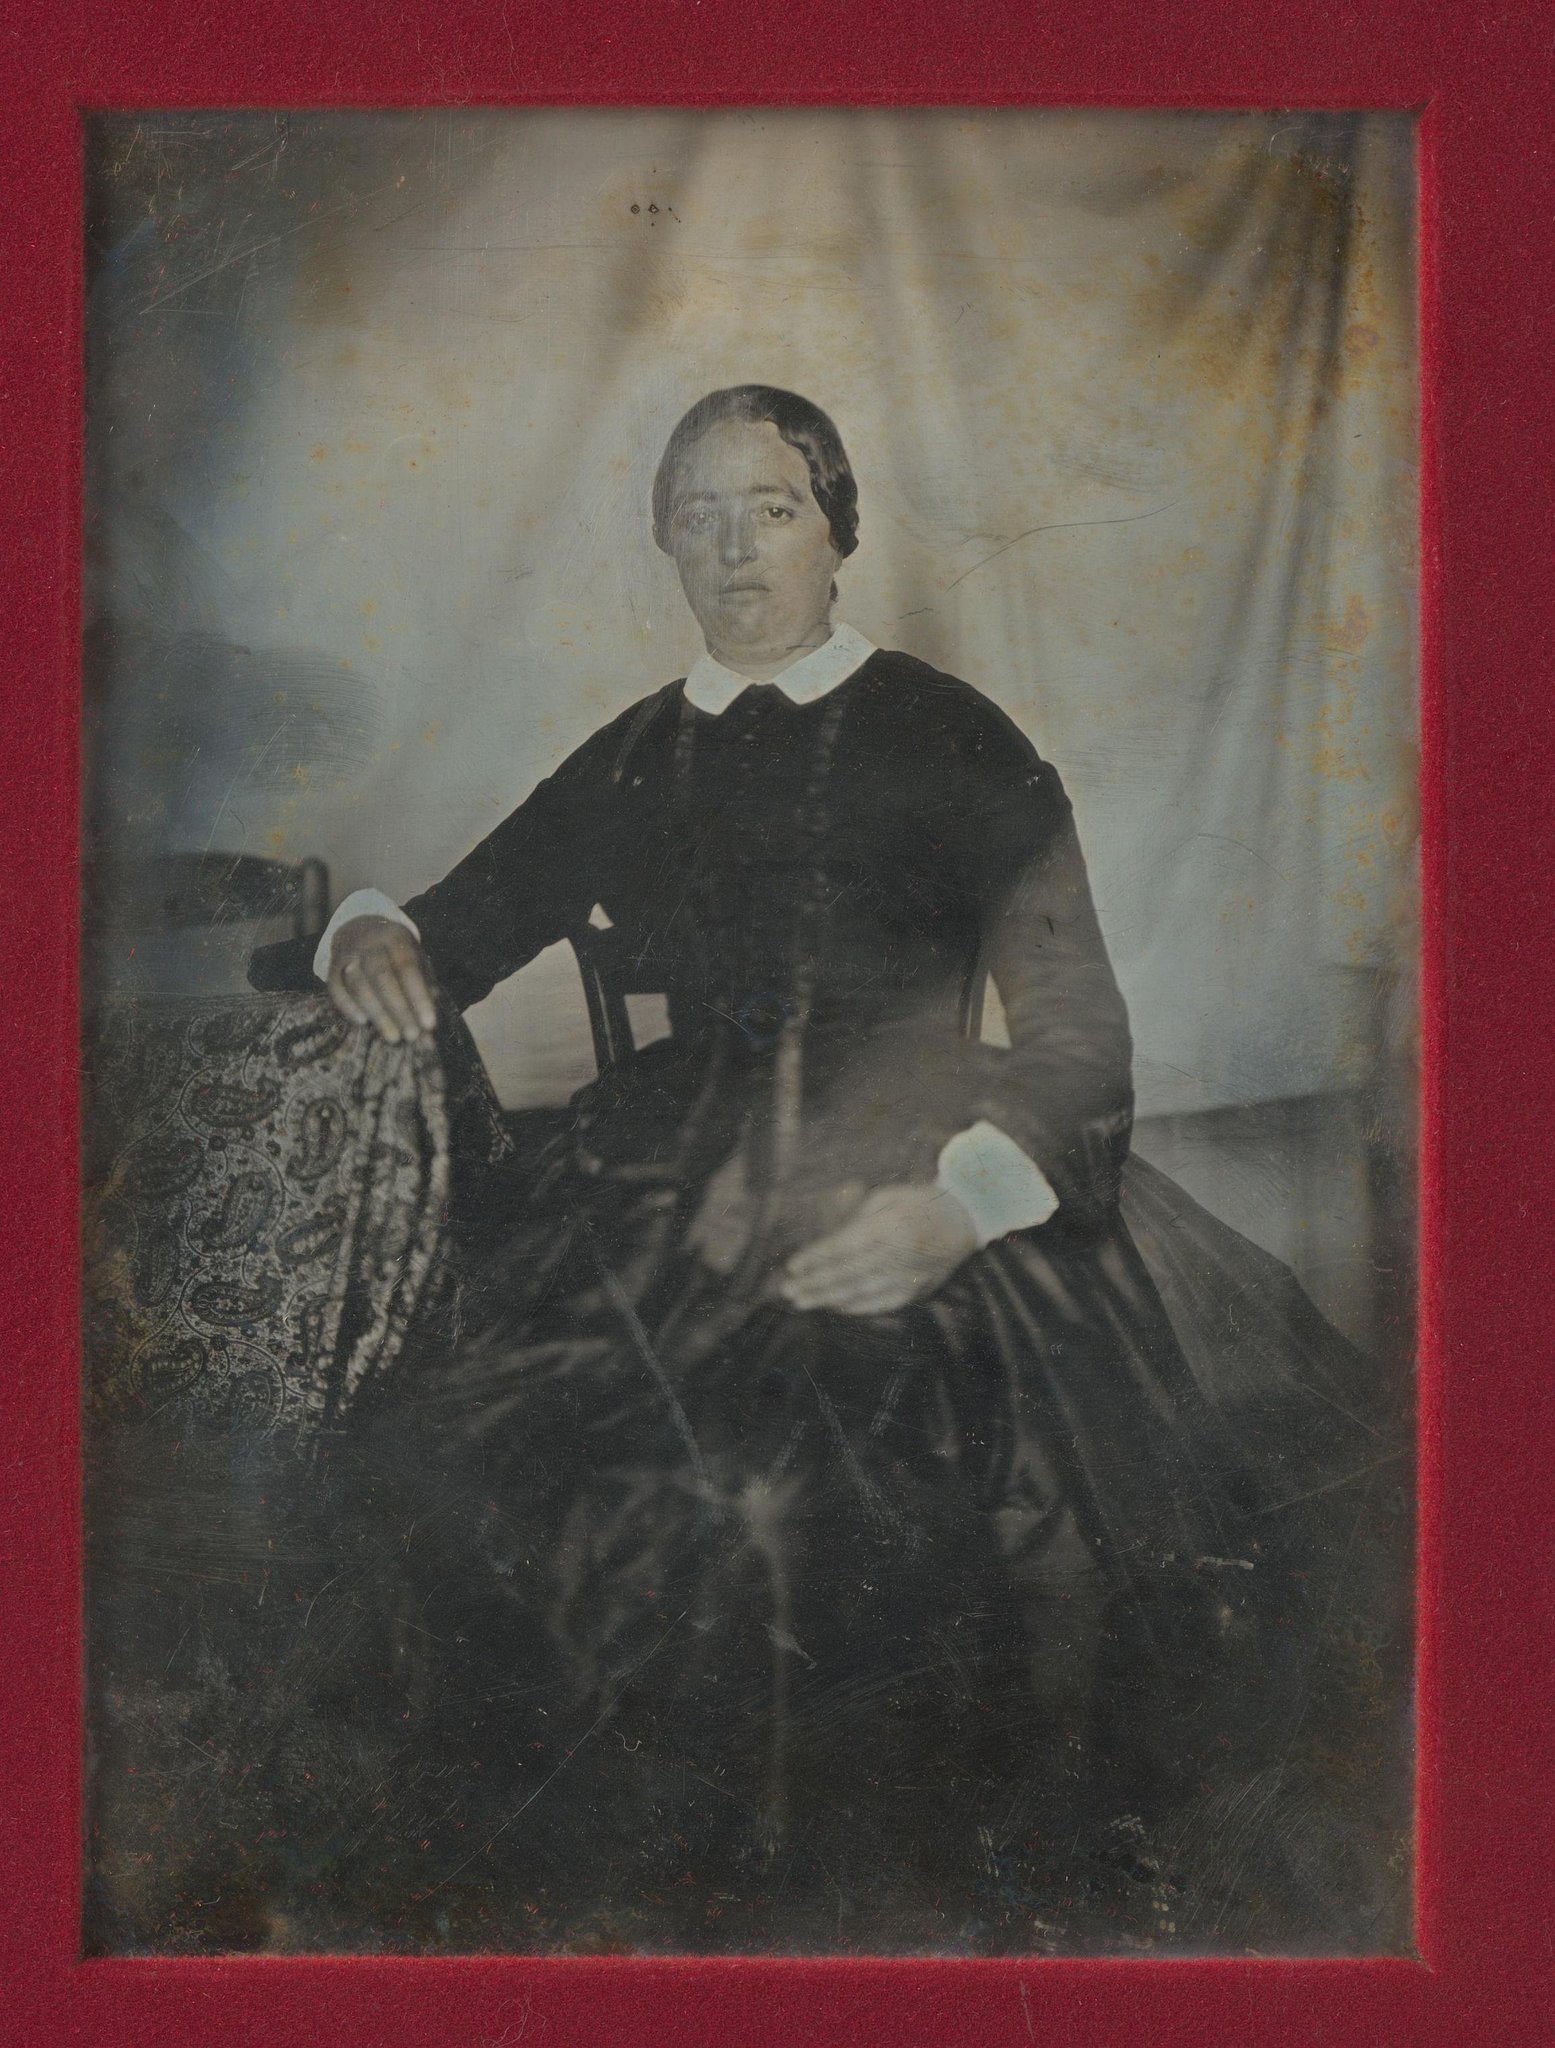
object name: photograph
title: Portret van een onbekende vrouw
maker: marc antoine gaudin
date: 1840-1860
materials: copper, glass, paper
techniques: daguerreotype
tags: adult woman, historical persons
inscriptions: inscription: ‘Deux "Dvble (Sic)/ de M? Antoine/ Gaudin’